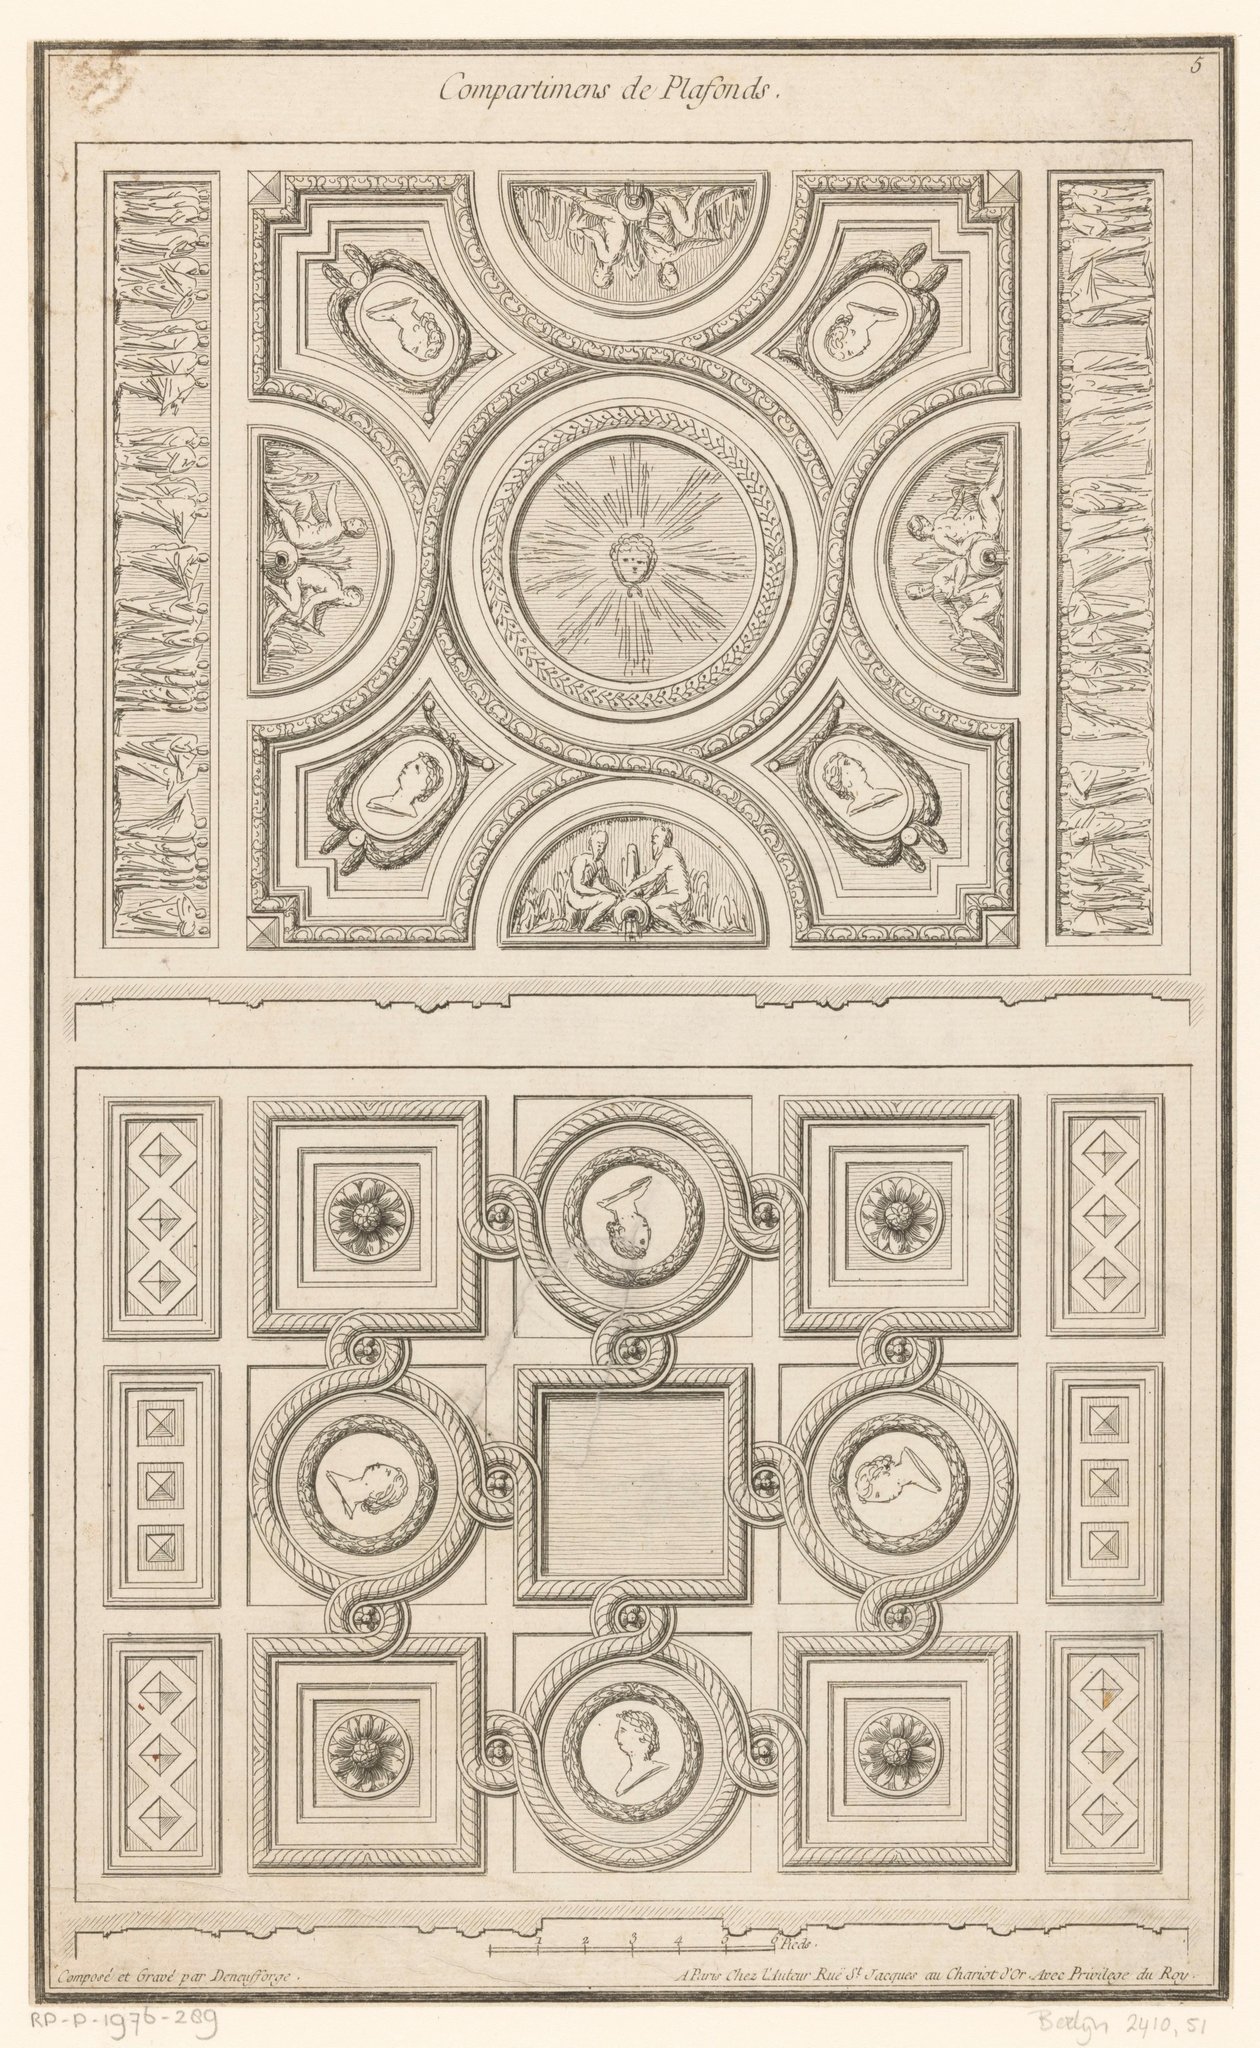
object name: print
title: Plafonds met de zon, figuren en medaillons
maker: jean françois de neufforge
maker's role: print maker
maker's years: 1714-1791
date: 1763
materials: paper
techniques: etching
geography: paris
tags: the (nude) human figure; 'corpo humano' (ripa), ornament ~ medallion, sun represented as face, wheel, etc., (decorated) ceiling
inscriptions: collector's mark: Lugt 2228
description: Een plafond met in het midden de zon, rondom halfronde cirkels met twee figuren op een kruik waar water uitstroomt en medaillons met portretten. Uiterst links en rechts panelen met figuren. Daaronder een plafond met medaillons met portretten en rozetten. Prentnummer 305.